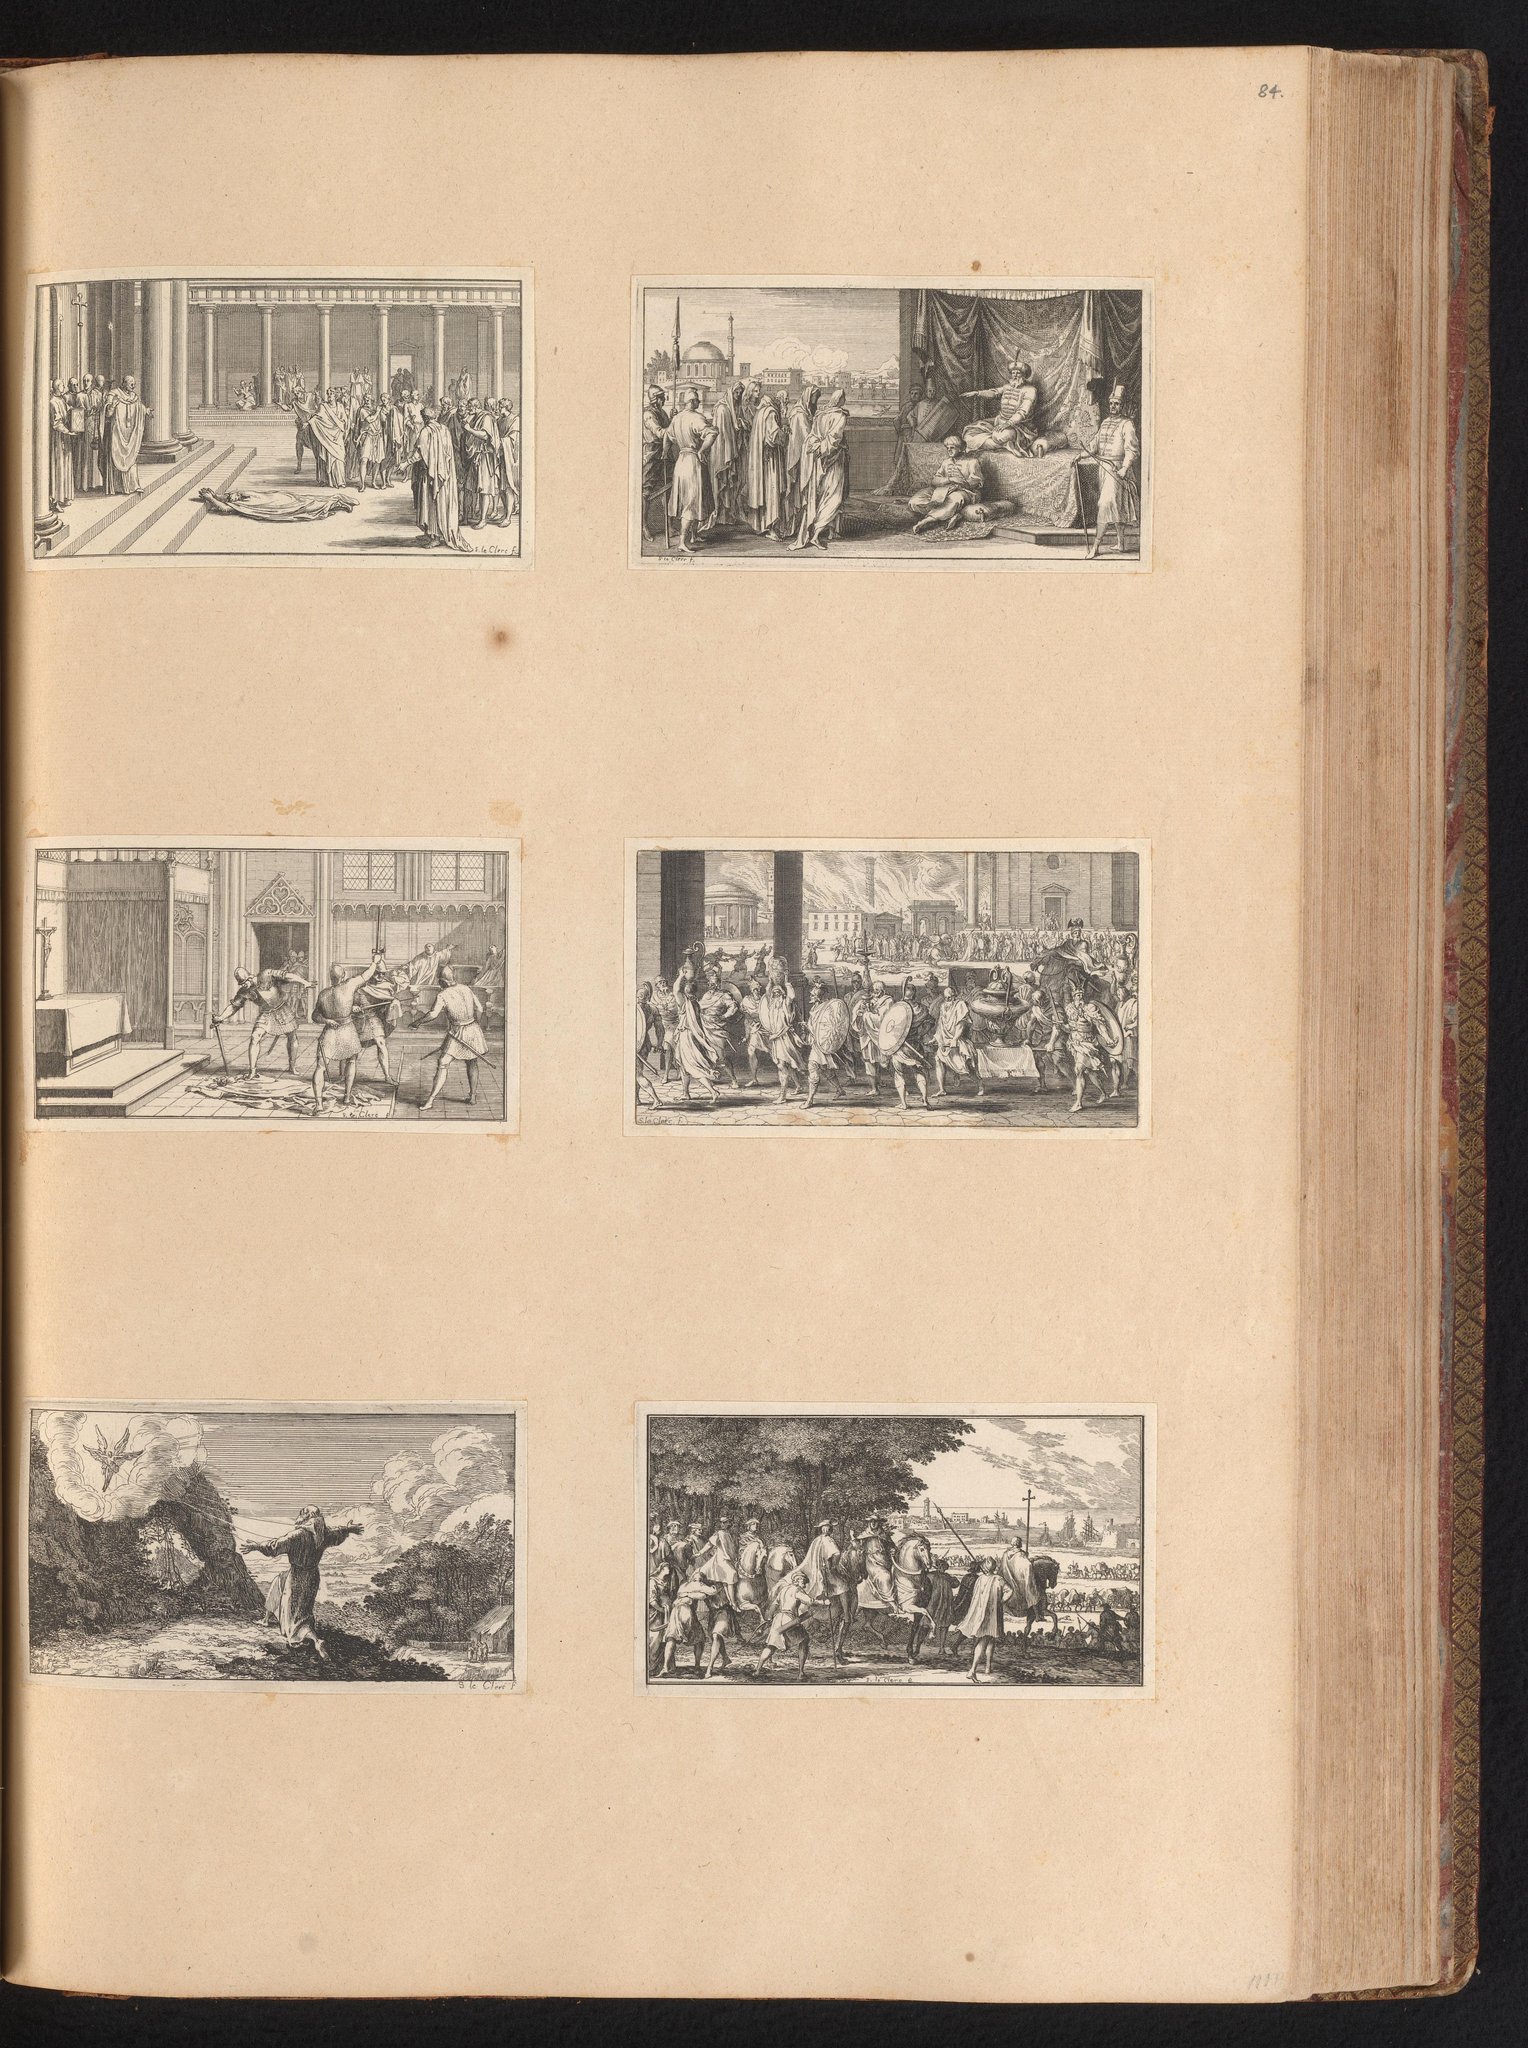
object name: album leaf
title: Zes vignetten uit verschillende delen van Abbé Claude Fleury's 'Histoire ecclésiastique (...)'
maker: sébastien leclerc (i)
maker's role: print maker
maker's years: 1637-1714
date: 1691-1738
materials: paper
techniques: etching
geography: paris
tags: vignette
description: Prenten uit: Fleury, Abbé Claude. Histoire ecclésiastique (...). Parijs: diverse uitgevers, 1691-1738.